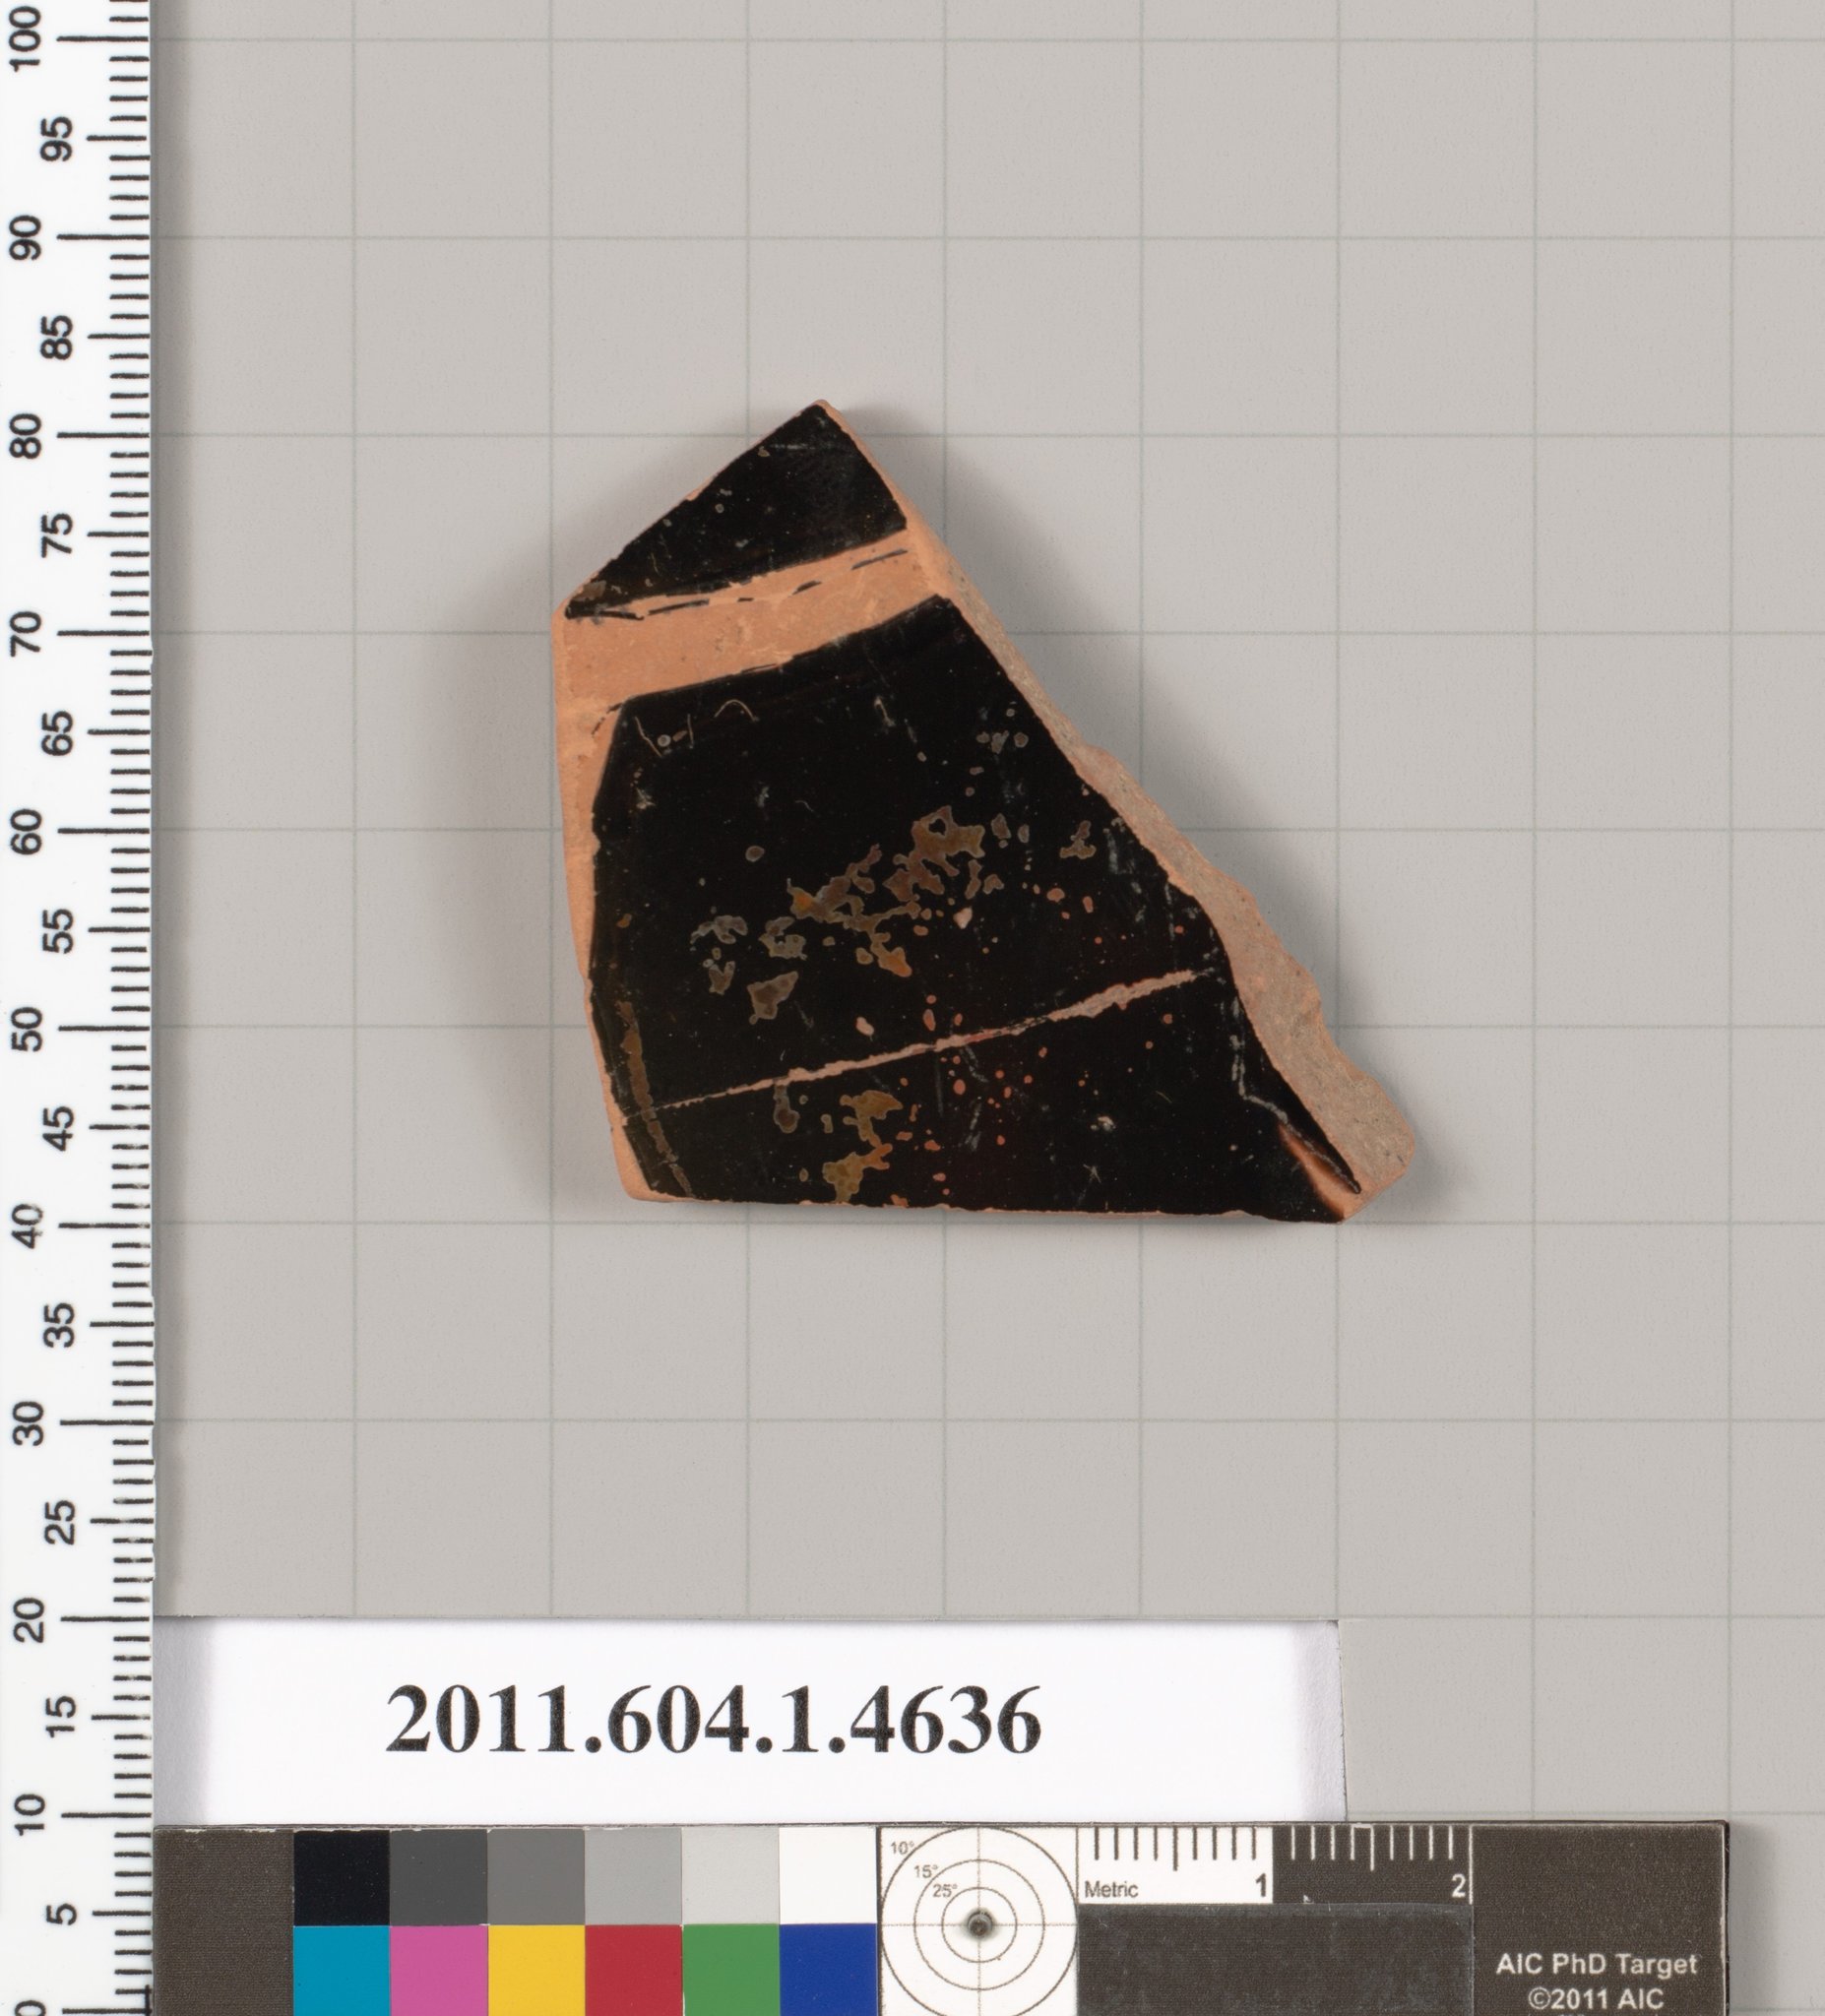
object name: kylix fragment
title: Terracotta fragment of a kylix (drinking cup)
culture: greek, attic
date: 480-470 BCE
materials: terracotta